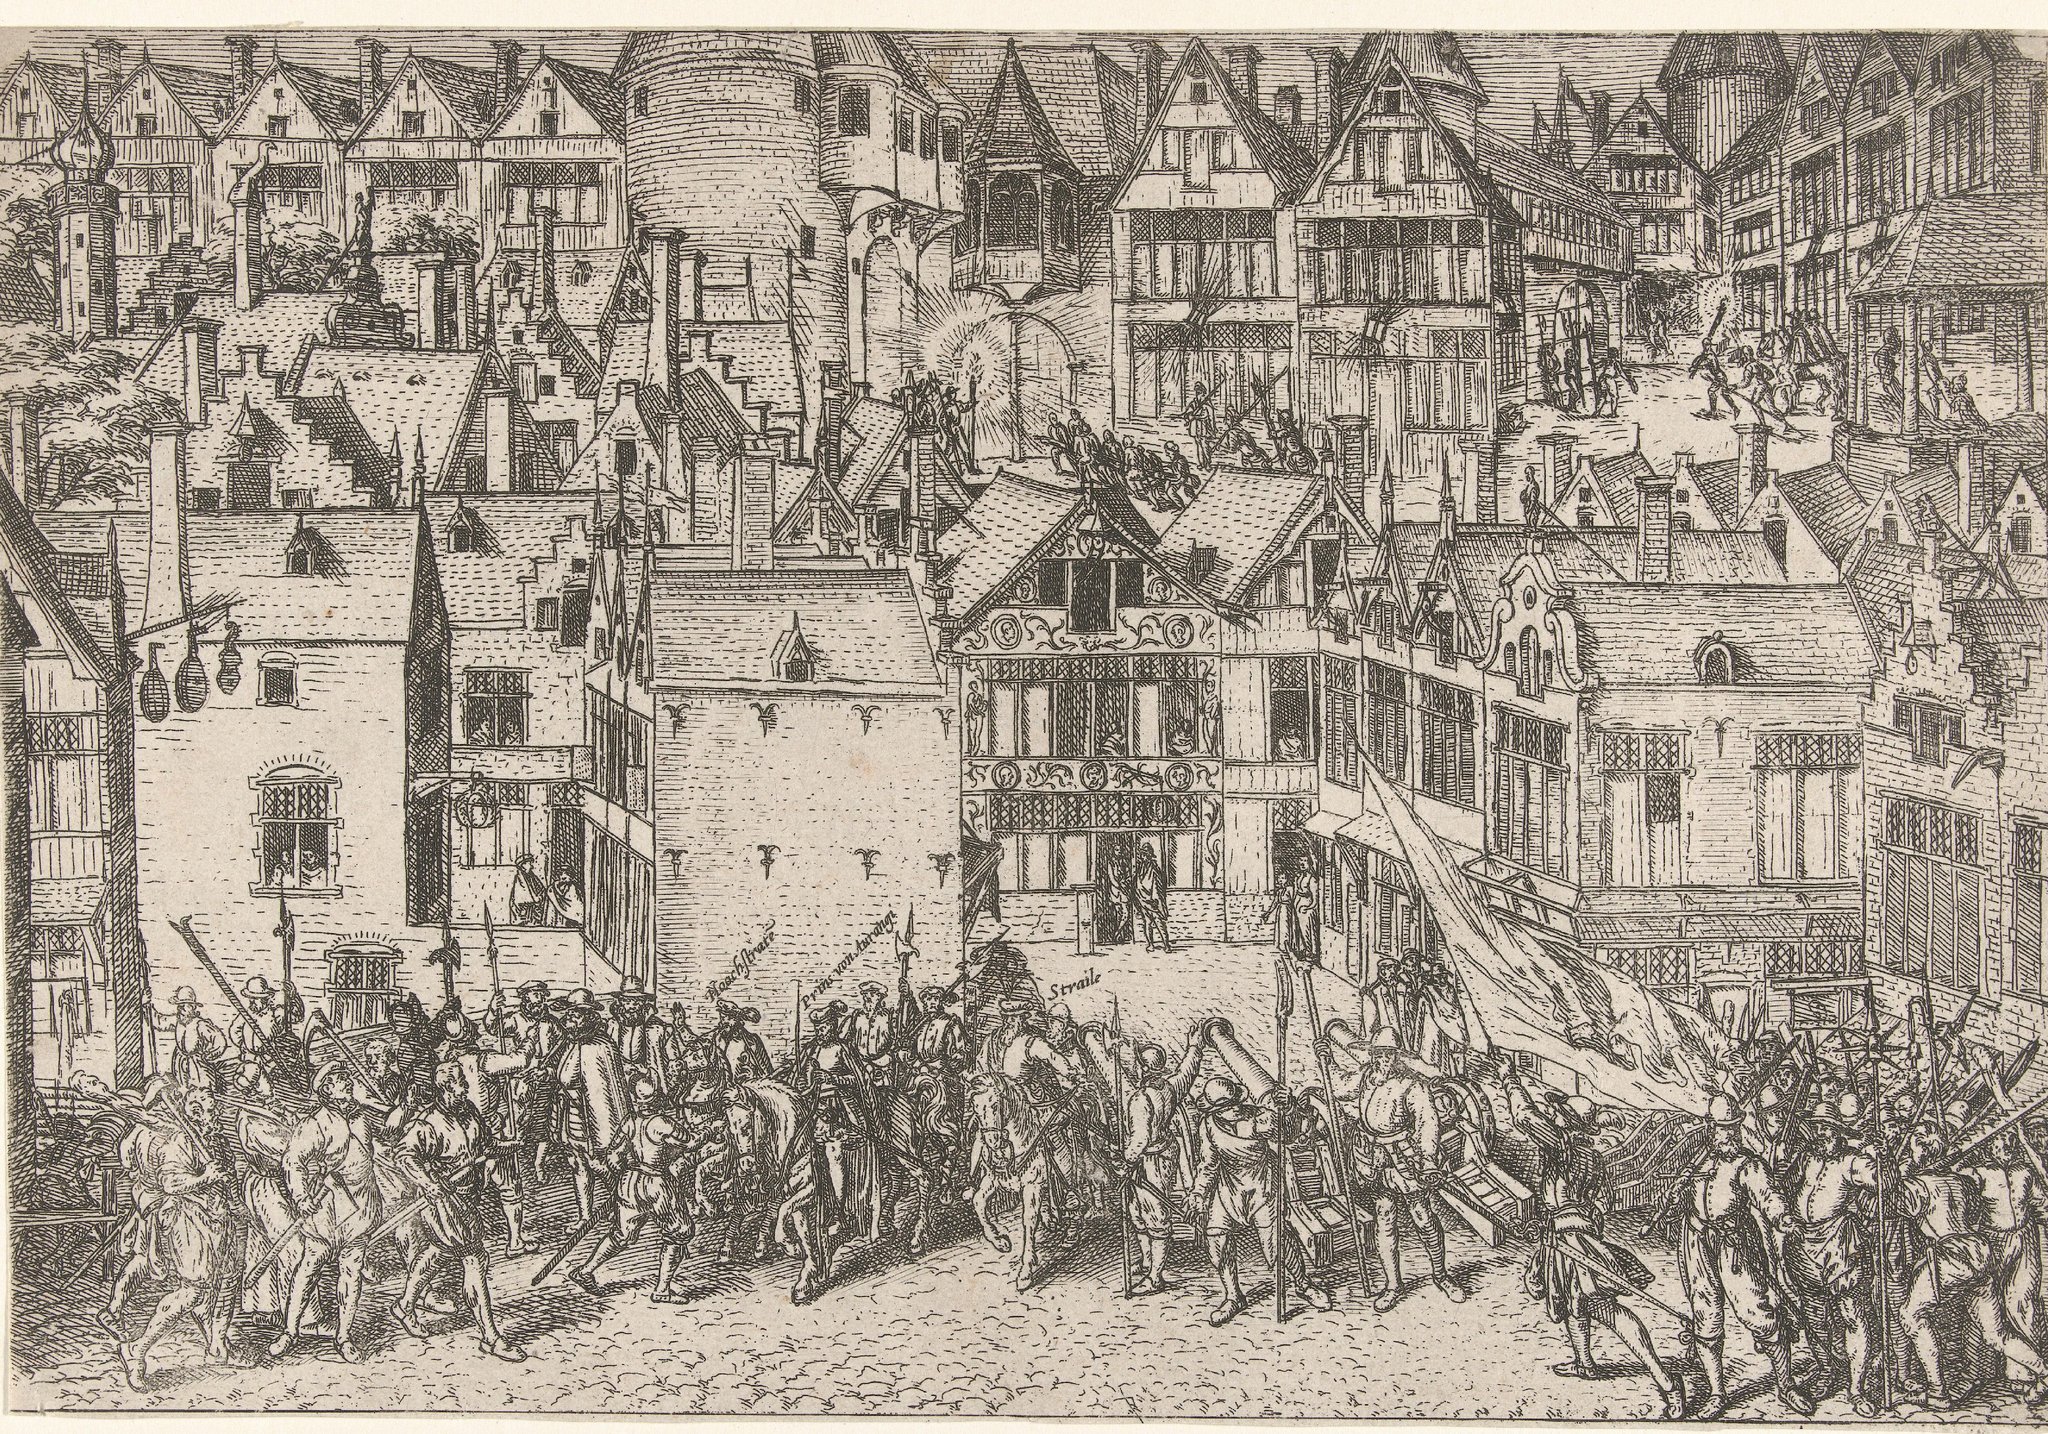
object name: print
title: Calvinistisch oproer in Antwerpen bedwongen, 1567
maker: frans hogenberg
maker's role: print maker, publisher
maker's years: 1538-1590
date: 1567-1570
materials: paper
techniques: etching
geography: cologne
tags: delft, william i (prince of orange), mayor, antwerp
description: Burgemeester Anton van Straelen, Hoogstraten en Willem van Oranje stillen calvinistisch oproer op de Meir in Antwerpen, 14 maart 1567.